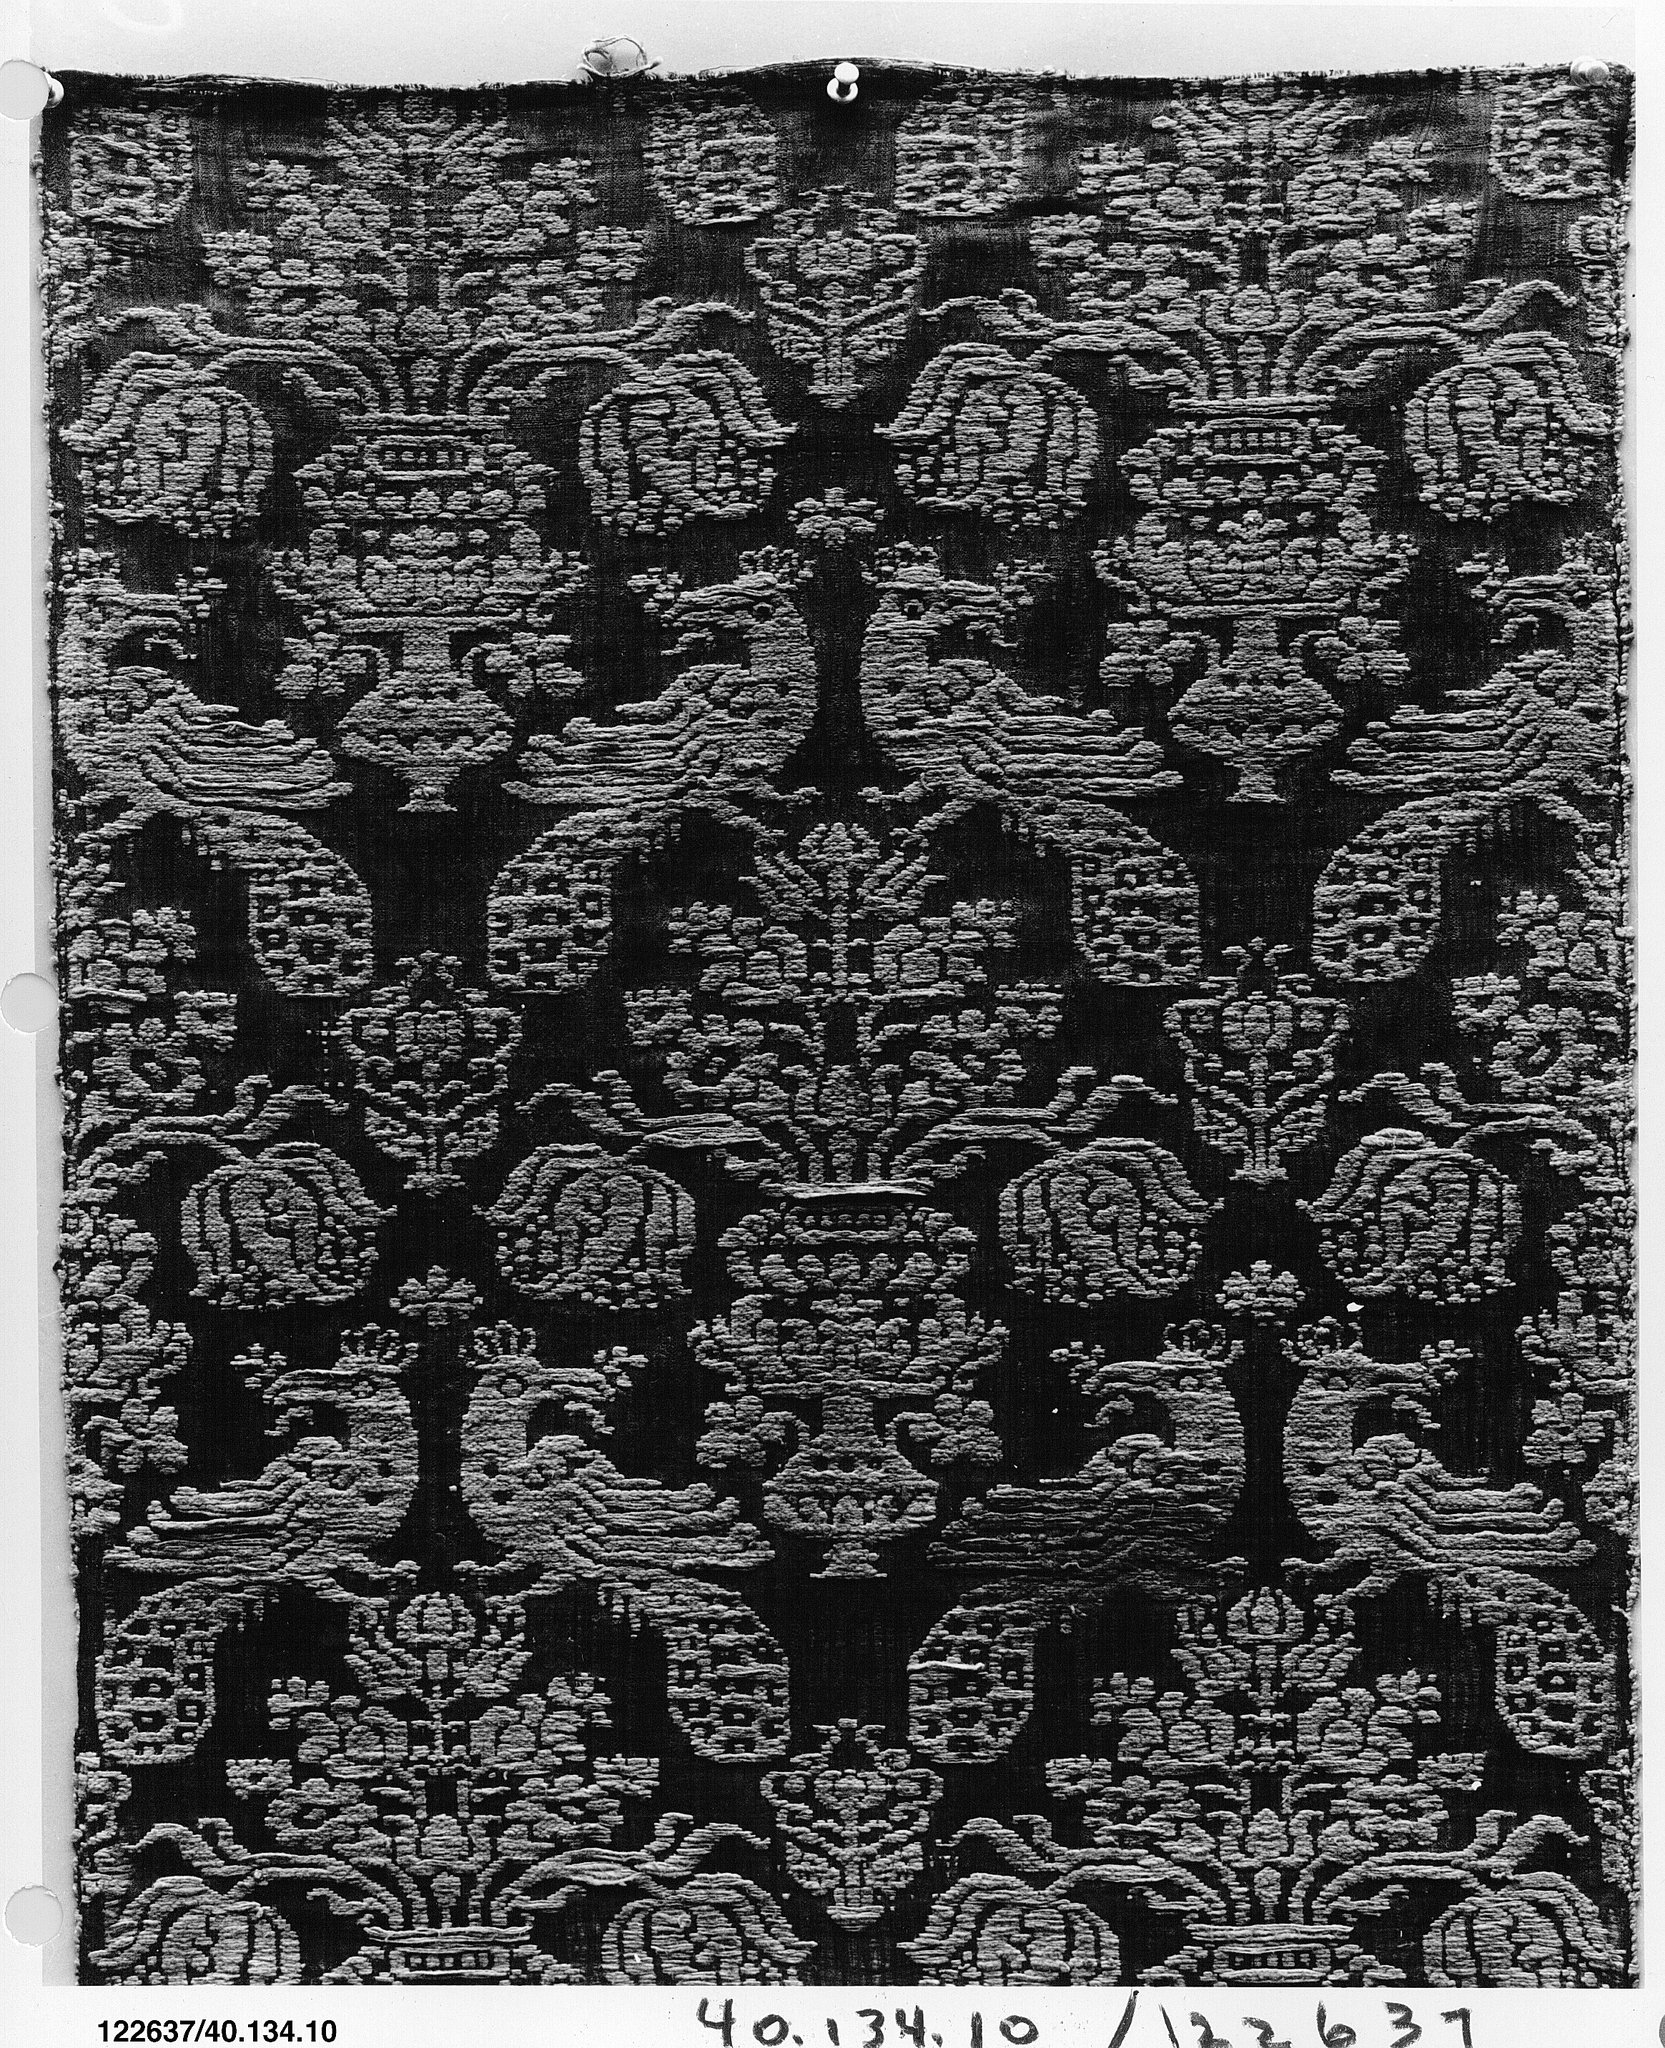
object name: piece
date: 1601-1700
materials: hemp, silk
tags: birds,flowers